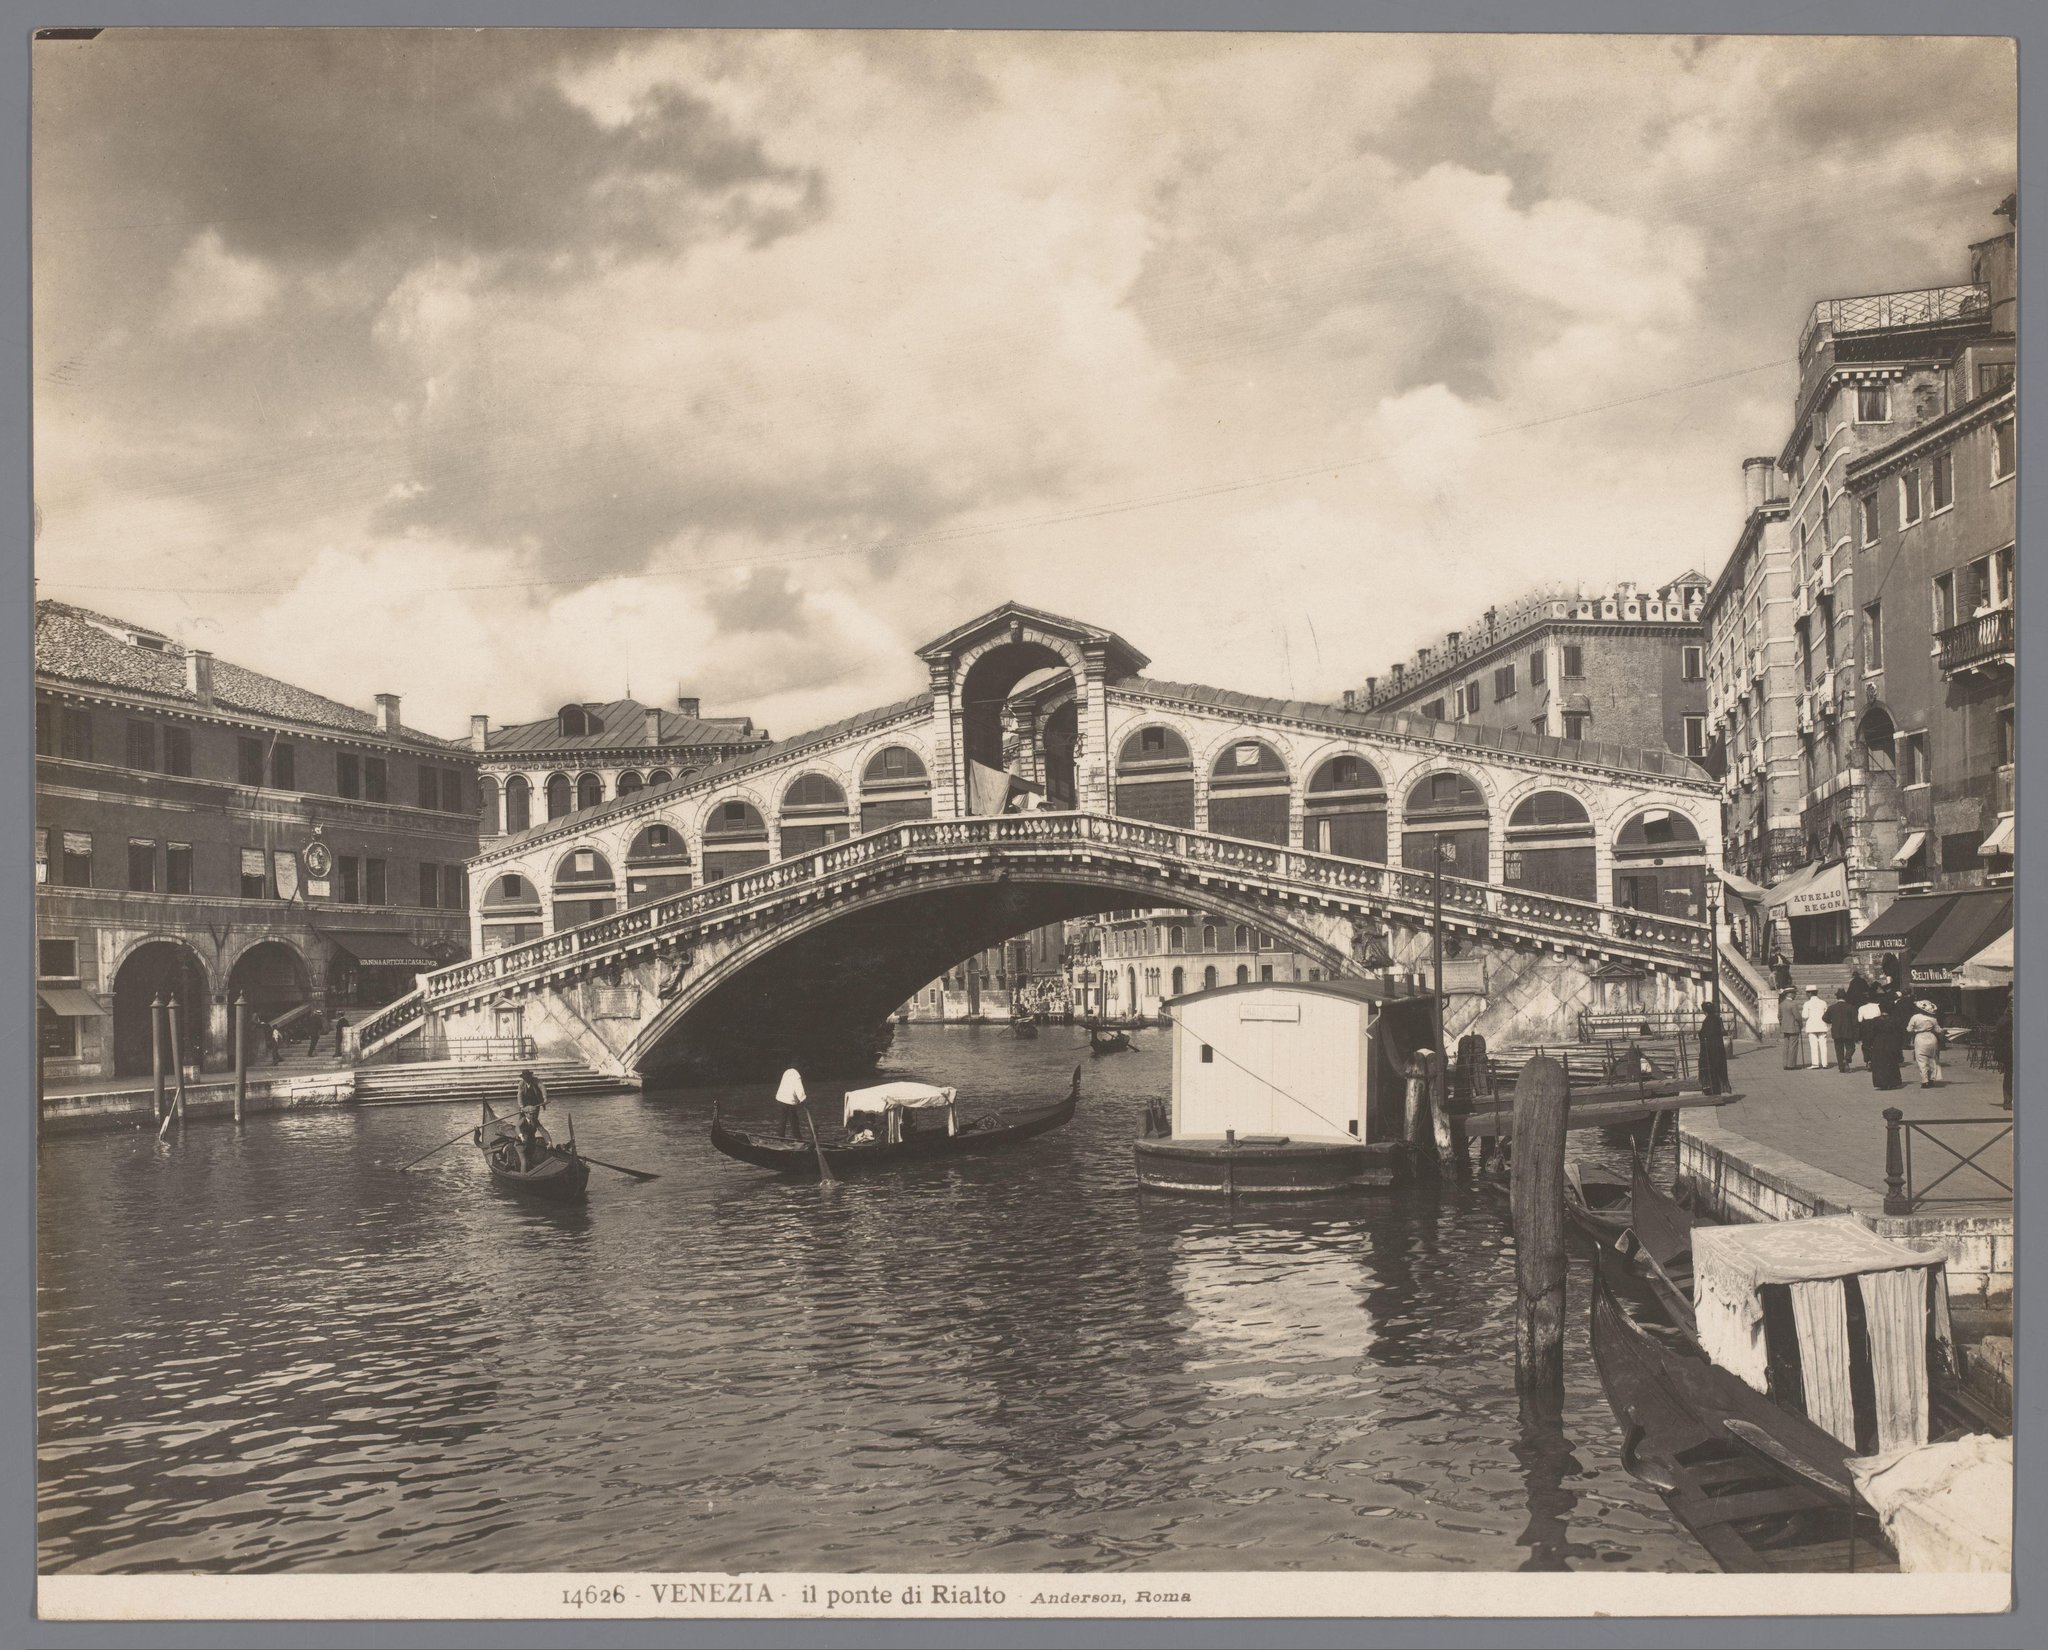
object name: photograph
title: Venezia, il ponte di Rialto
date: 1885-1930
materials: paper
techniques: gelatin silver print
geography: venice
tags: bridge in city across river, canal, etc.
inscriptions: number: ‘14626.’